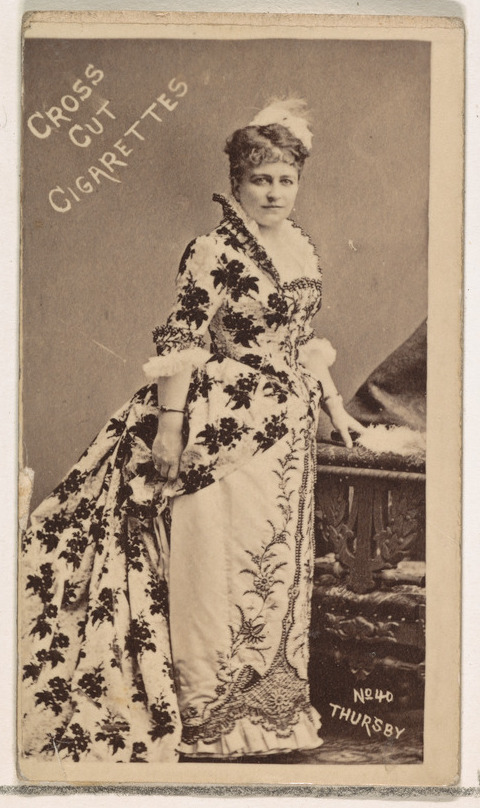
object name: print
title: Card Number 40, Thursby, from the Actors and Actresses series (N145-1) issued by Duke Sons & Co. to promote Cross Cut Cigarettes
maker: w. duke, sons & co.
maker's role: publisher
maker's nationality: american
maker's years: 1870-1920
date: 1880-1889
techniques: albumen silver print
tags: portraits,women,actresses